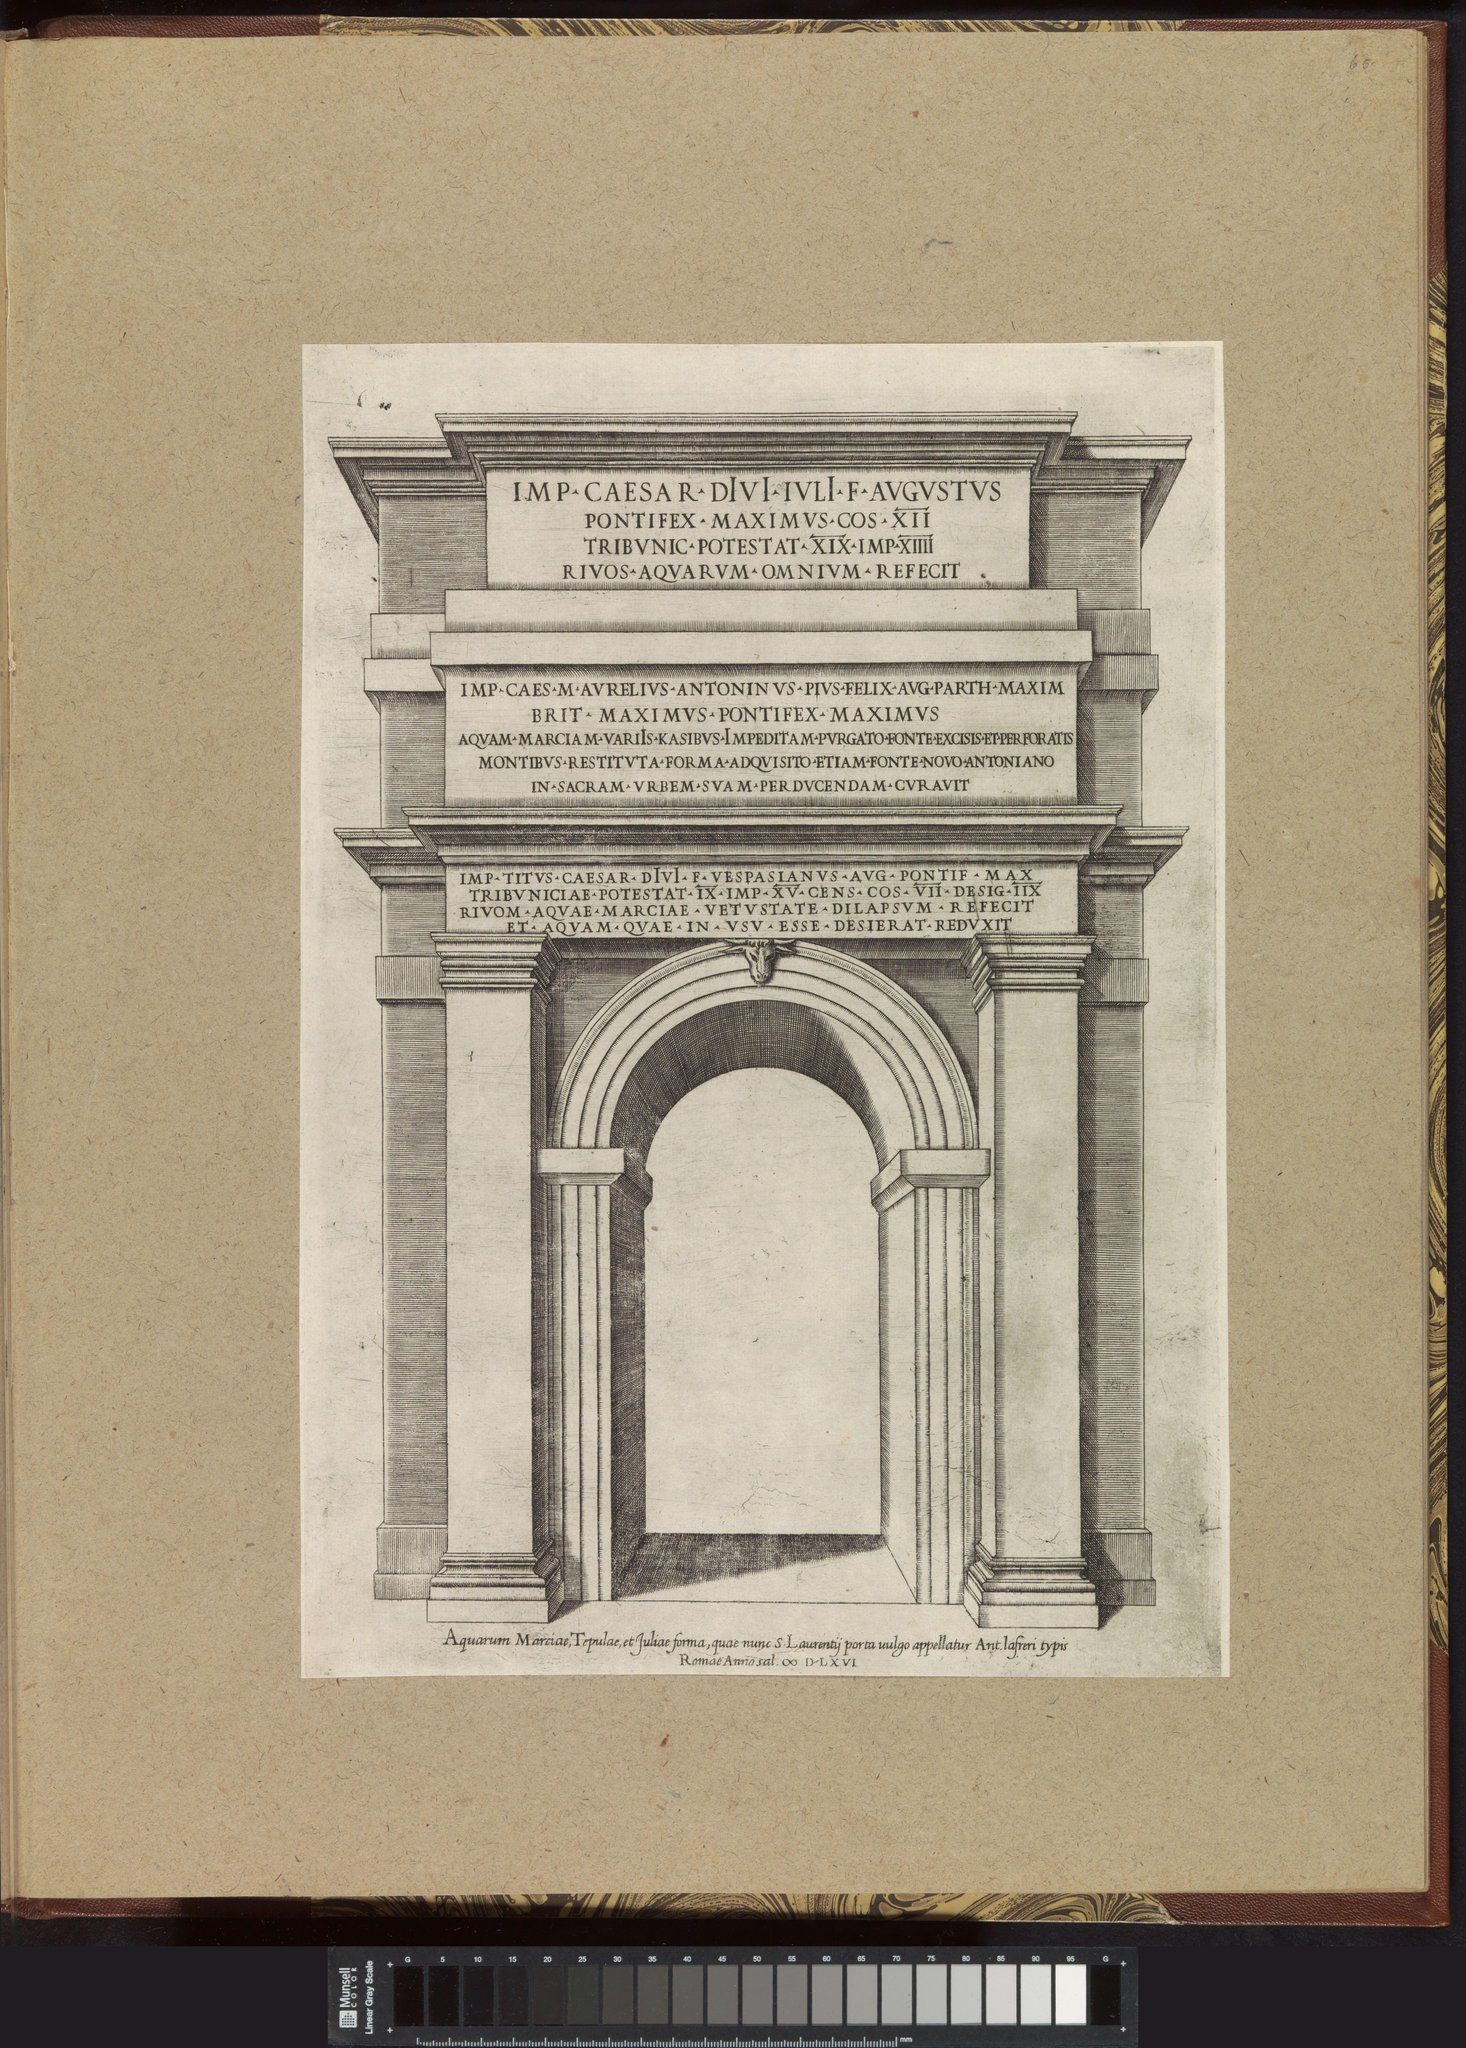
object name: print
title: Speculum Romanae Magnificentiae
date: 1566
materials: paper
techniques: engraving, etching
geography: rome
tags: representation of real building (either existing or having existed), city-gate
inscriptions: date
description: Deze prent behoort tot het prentcorpus dat bekend staat als de ‘Speculum Romanae Magnificentiae’ (‘Spiegel van Romeinse pracht’). Dit corpus, bestaande uit prenten met voorstellingen van kunstwerken en gebouwen uit het antieke en het moderne Rome, vond zijn oorsprong bij uitgevers Antonio Salamanca en Antonio Lafreri. Deze twee buitenlandse uitgevers bundelden hun krachten te Rome in de periode 1553-1563. Hun prenten werden al snel razend populair bij toeristen en verzamelaars, die de prenten individueel of in grote groepen aanschaften. Grote groepen Speculum-prenten werden vaak op aanvraag samengebonden in albums. Er zijn verschillende Speculum-albums overgeleverd die allemaal verschillen van inhoud. Tussen 1573 en 1577 gaf Antonio Lafreri een speciale titelpagina uit (met de titel ‘Speculum Romanae Magnificentiae’) die mensen voor hun verzamelingen konden voegen. Het overlijden van Lafreri in 1577 betekende niet het einde van het corpus. Een groot deel van de koperplaten ging over op Claudio en Stefano Duchetti. De rest raakte verspreid over verschillende andere uitgevers. De populariteit van de Speculum-prenten wist nog geruime periode uitgevers te inspireren tot het laten maken van kopieën en het toevoegen van nieuwe prenten aan het corpus.